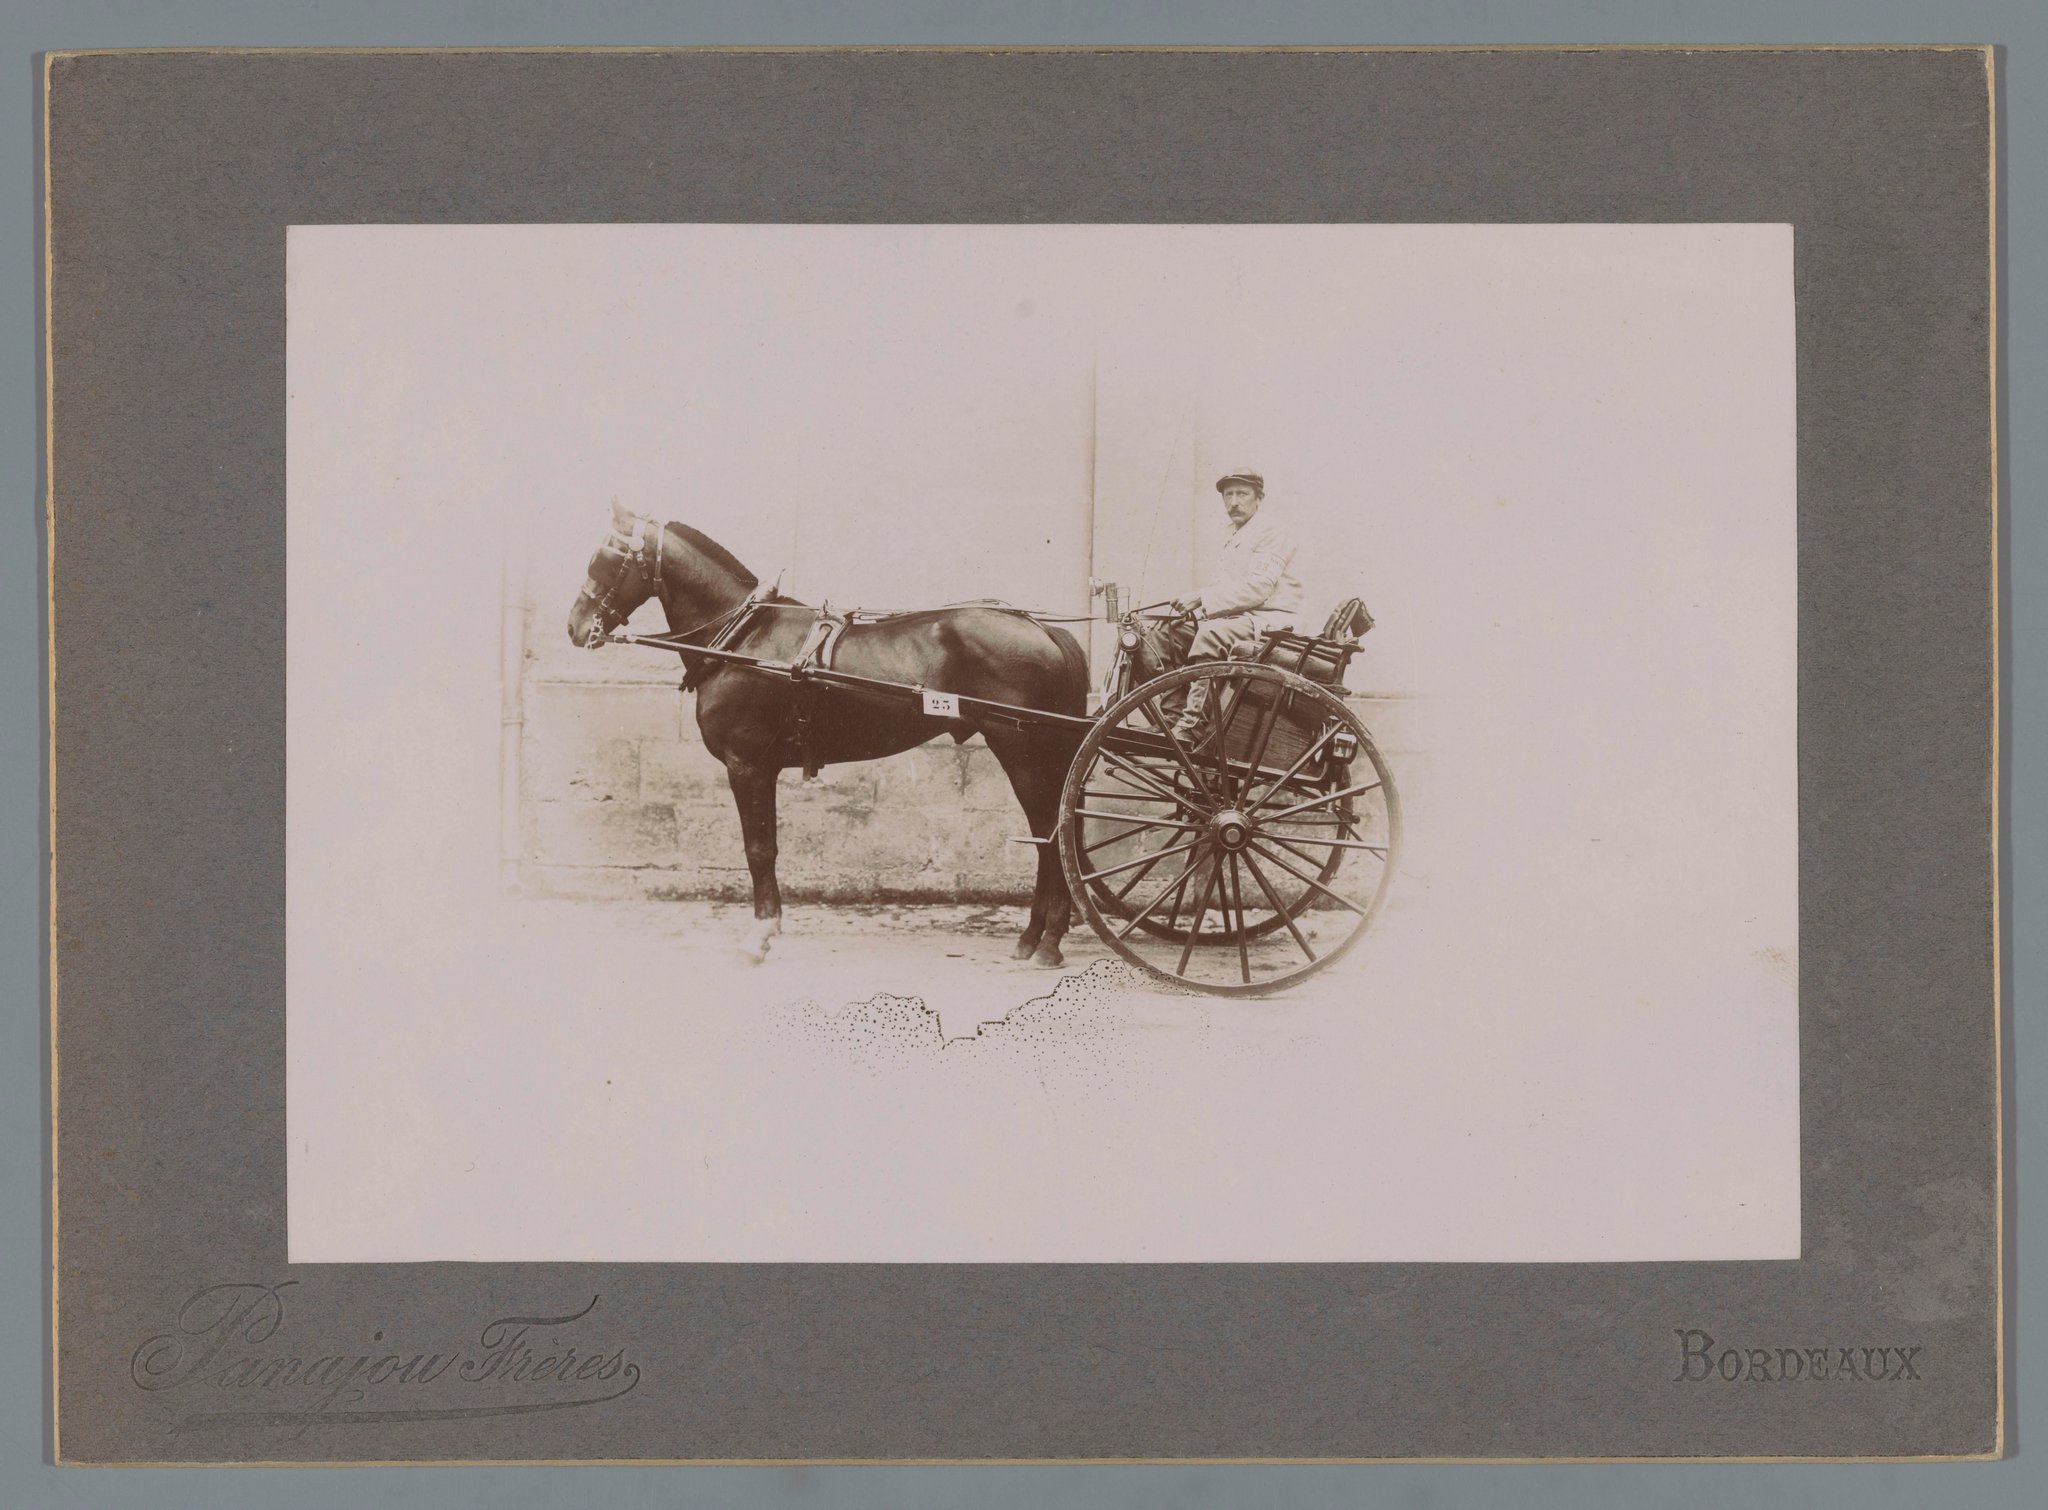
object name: photograph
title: Portret van een onbekende man op een paardenkoets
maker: panajou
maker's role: fotograaf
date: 1900-1910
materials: cardboard, photographic support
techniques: gelatin silver print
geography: bordeaux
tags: adult man, four-wheeled, animal-drawn vehicle, e.g.: cab, carriage, coach, horse